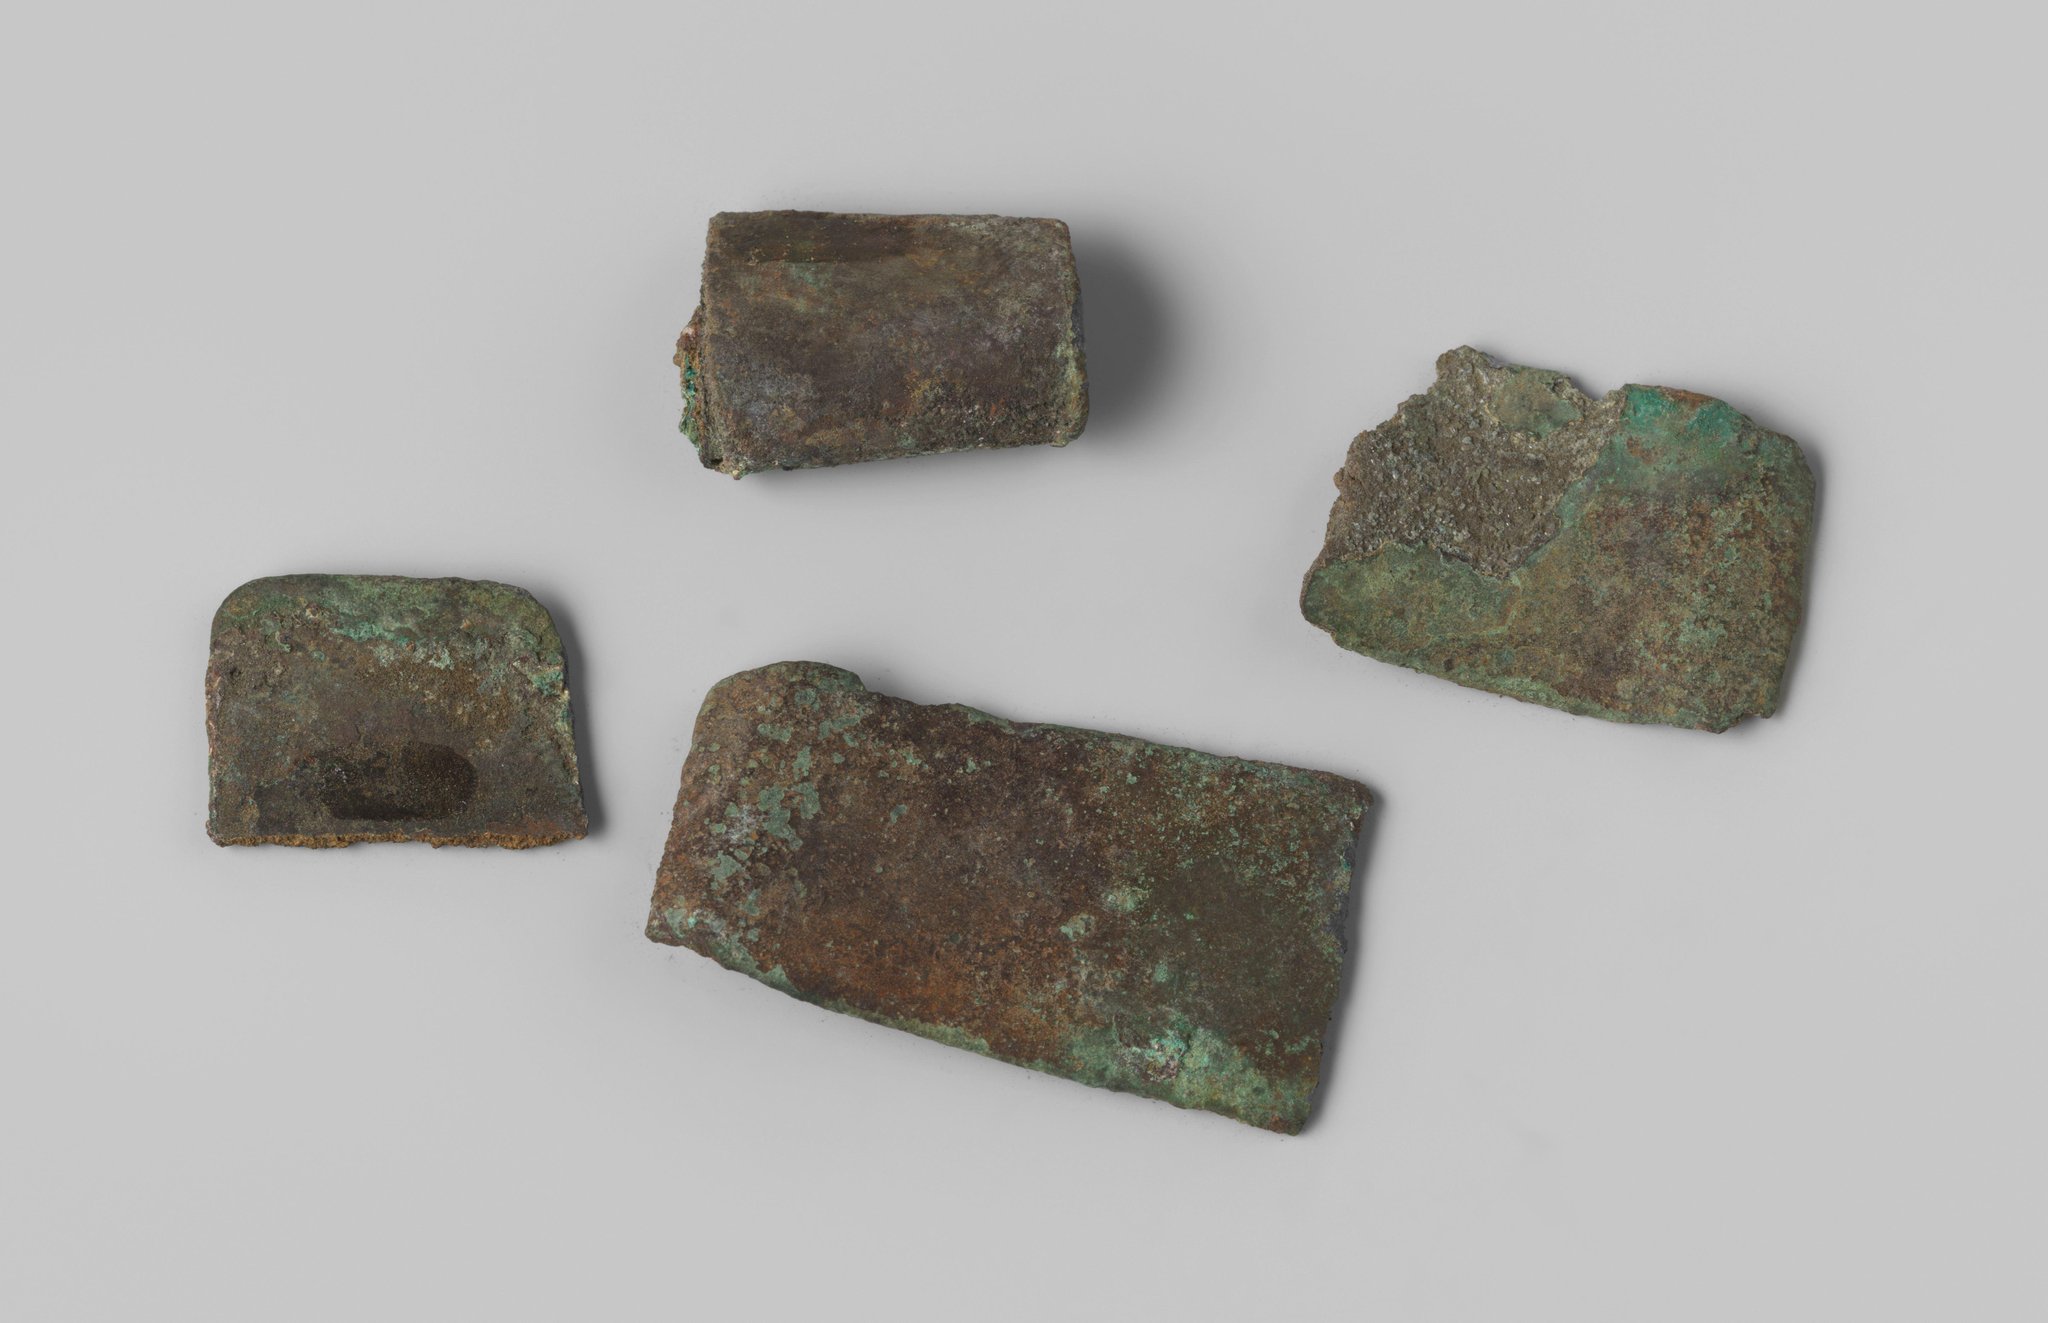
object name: firehose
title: Fragmenten brandslangringen uit het wrak van de Oost-Indiëvaarder Hollandia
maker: Anonymous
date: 1700-1743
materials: copper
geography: netherlands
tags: verenigde oostindische compagnie, hollandia (schip), annet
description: Fire engine, firehose; fragm, id. NG 1975-20H1271a, broken.